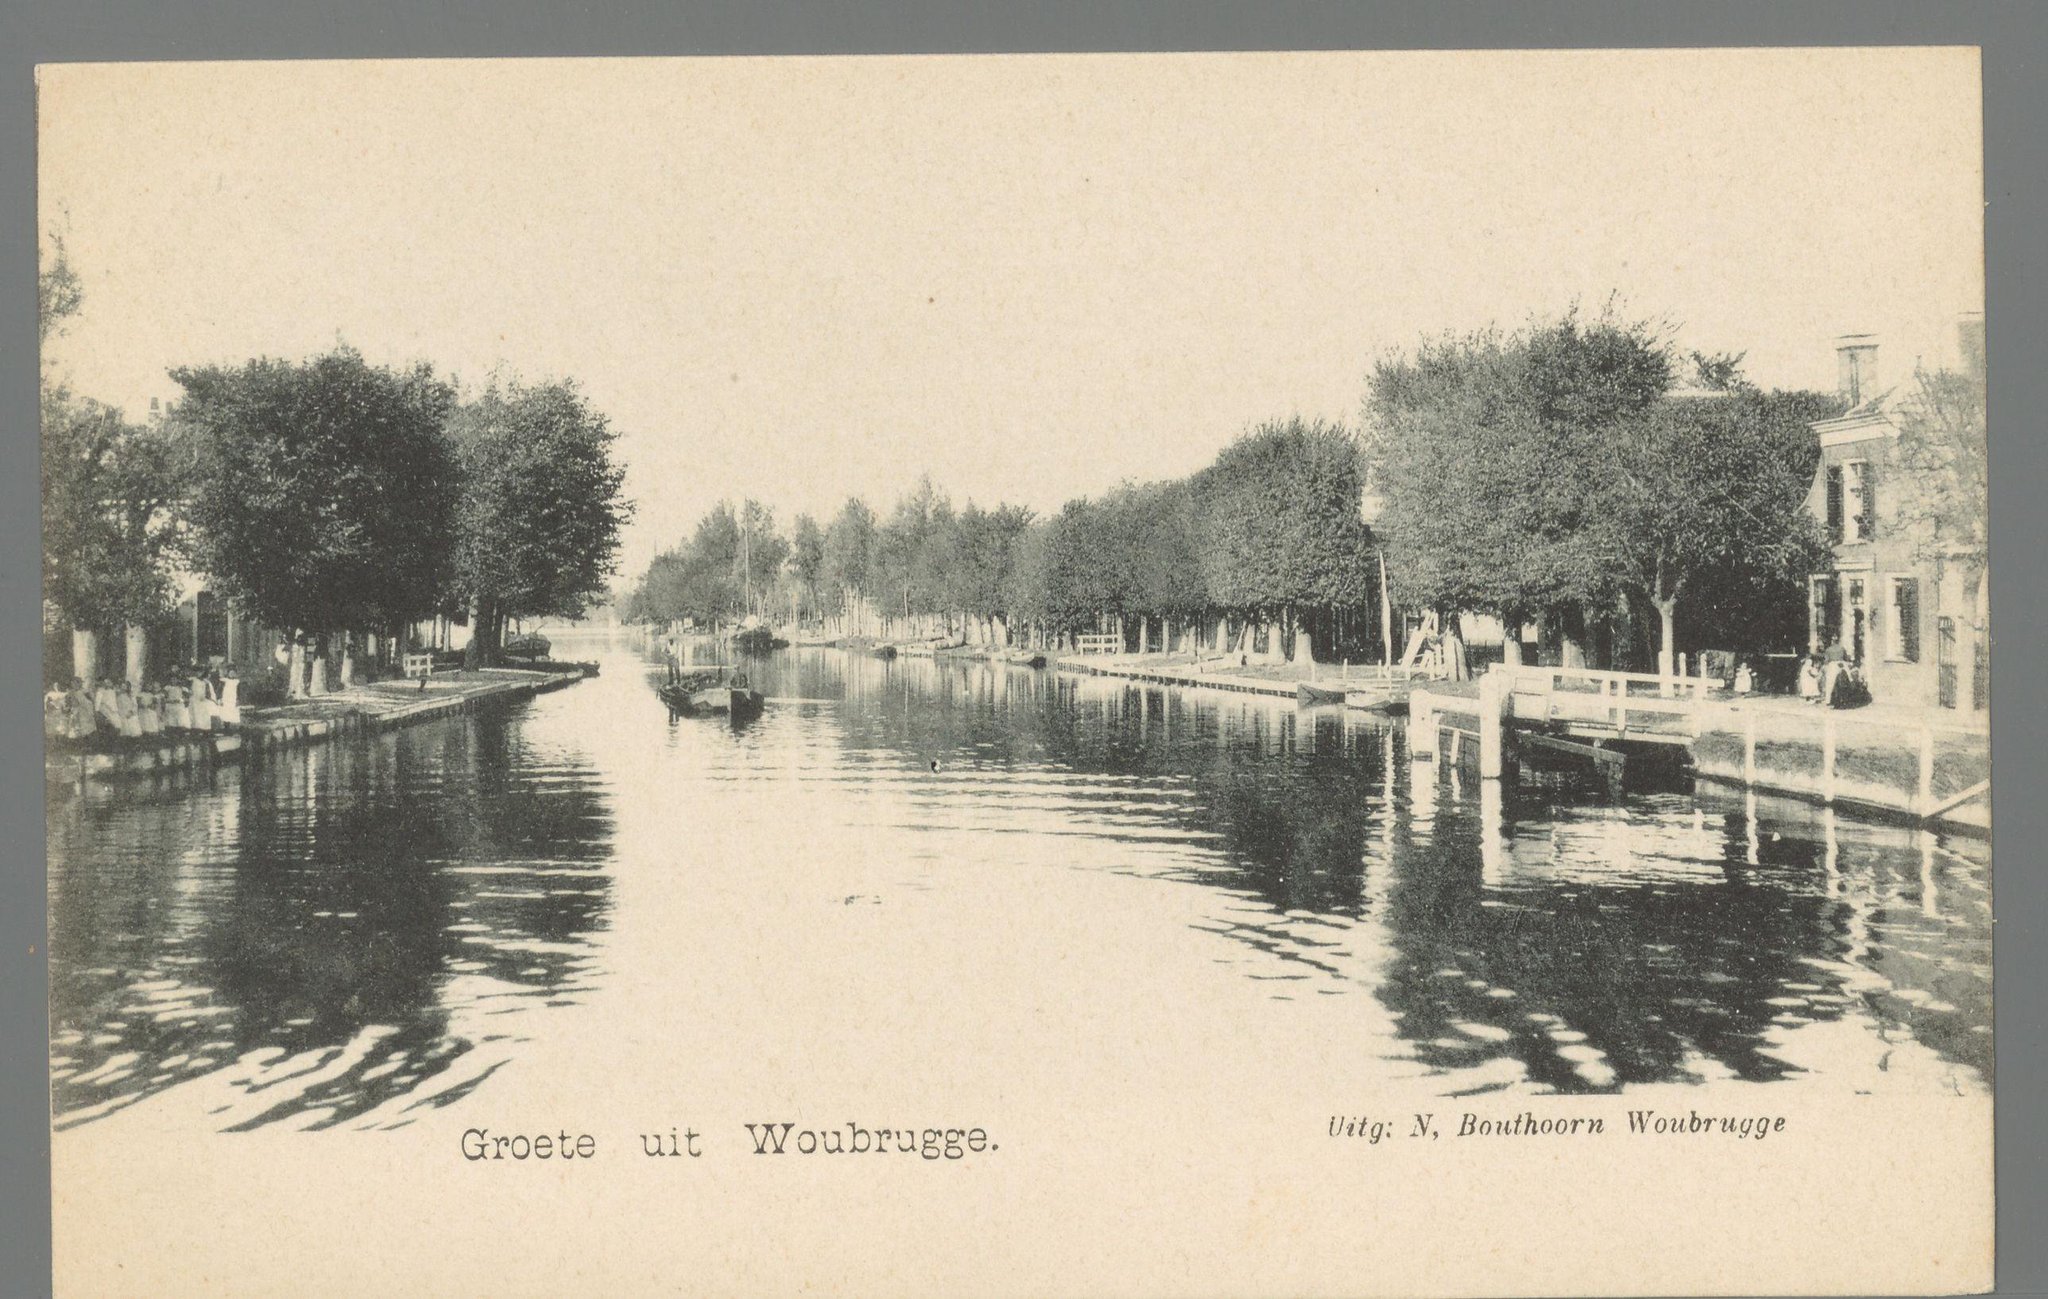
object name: ansichtkaart, prentbriefkaart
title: Groete uit Woubrugge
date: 1897-1905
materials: cardboard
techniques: photograph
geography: woubrugge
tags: canals, waters (in village), street